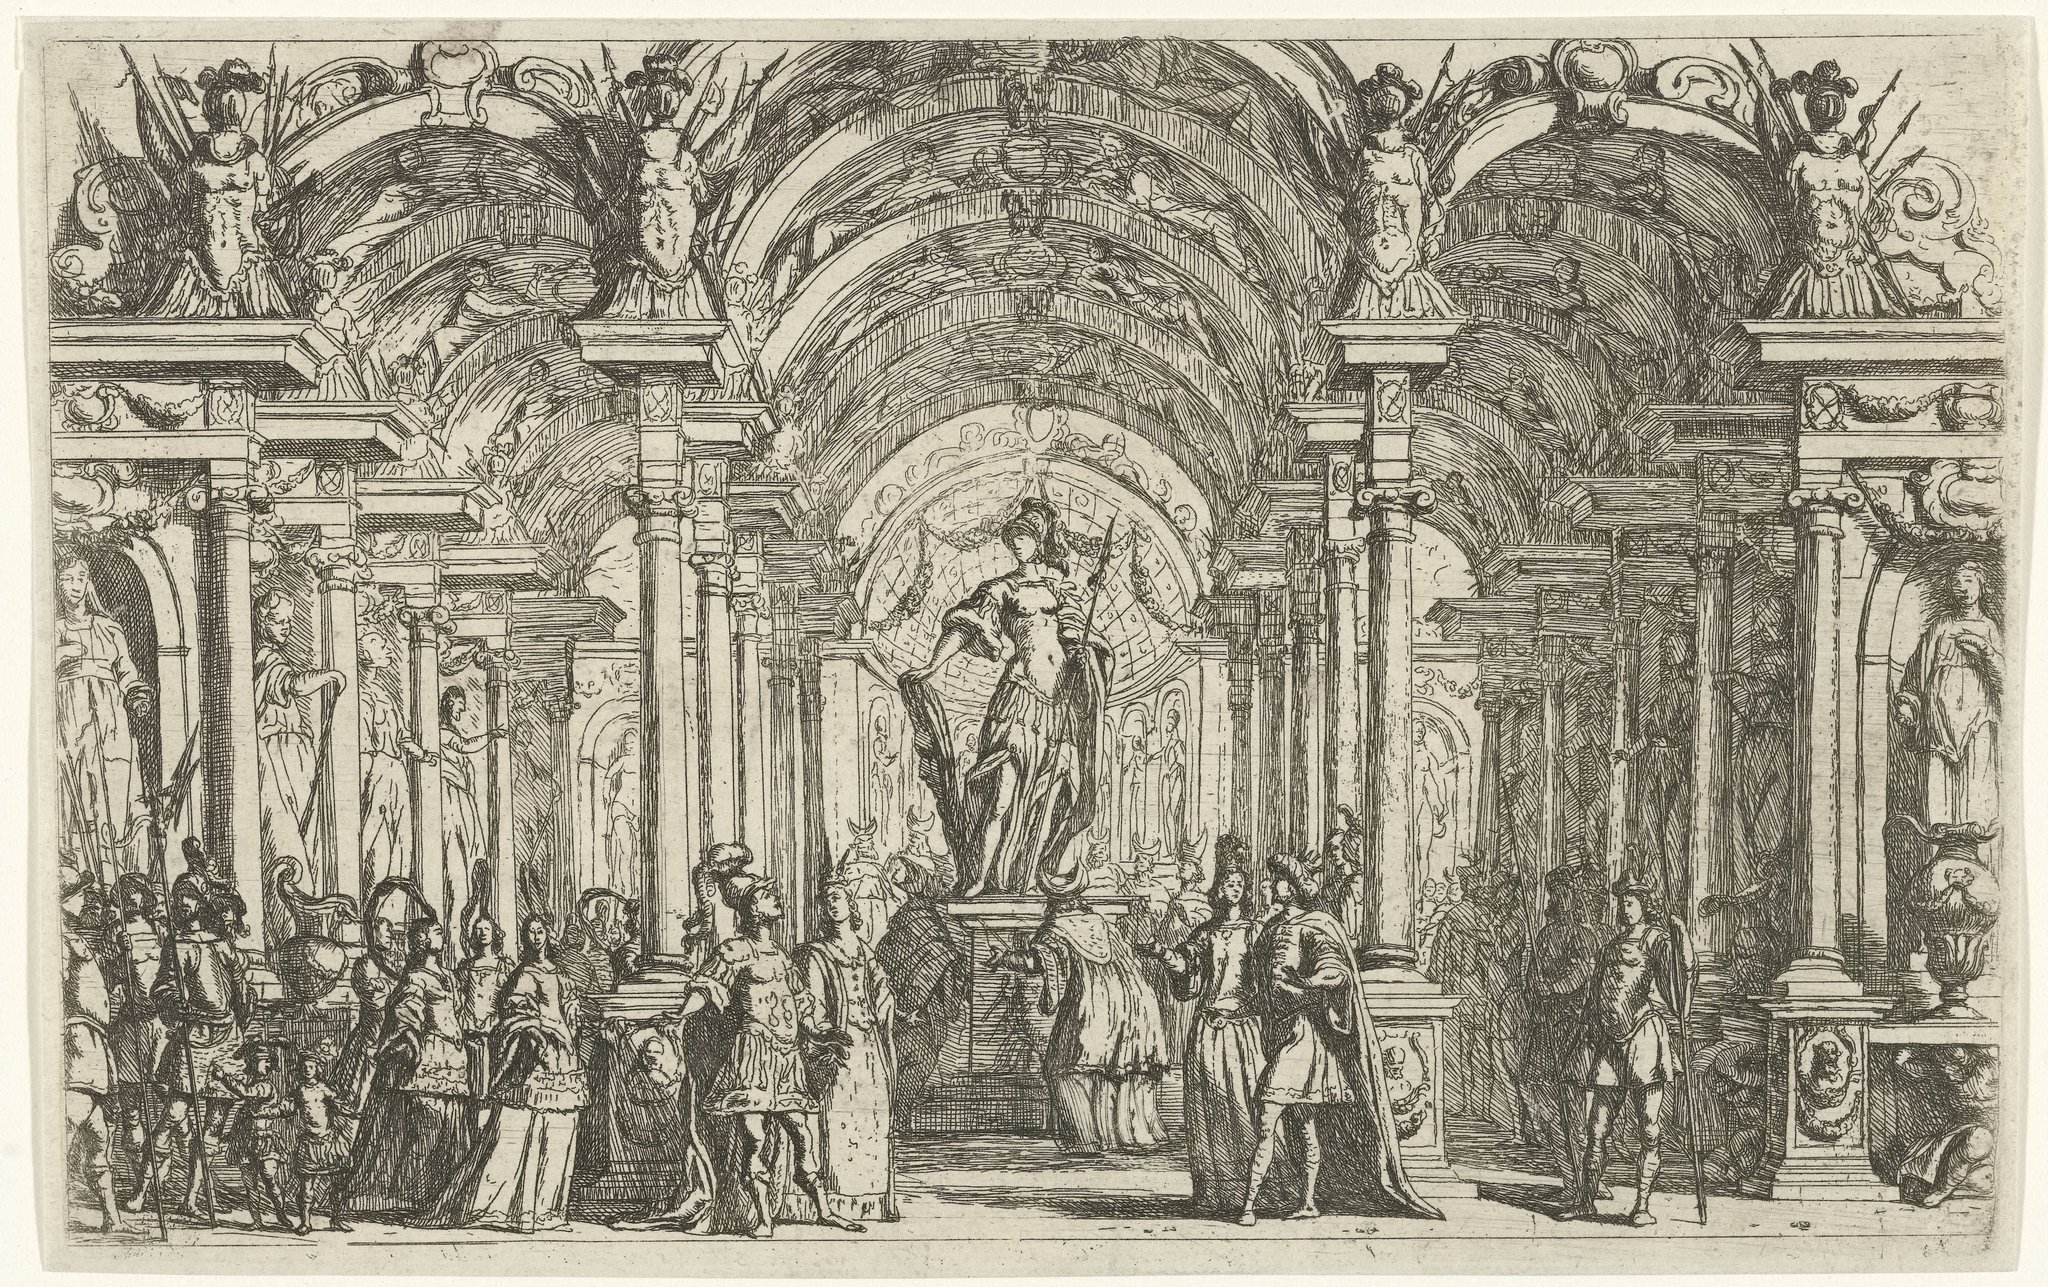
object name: print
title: Ontwerpen voor toneeldecor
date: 1663-1674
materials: paper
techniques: etching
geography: vienna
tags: set, scenery ~ stage, theatre, theatrical performance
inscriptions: collector's mark: Lugt 2228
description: In een grote zuilenhal aan het hof staan op de voorgrond twee paren tegenover elkaar. In het midden tussen hen in een beeld van een heerser in Romeinse kledij. De gangen van de hal zijn gevuld met soldaten en hofleden.